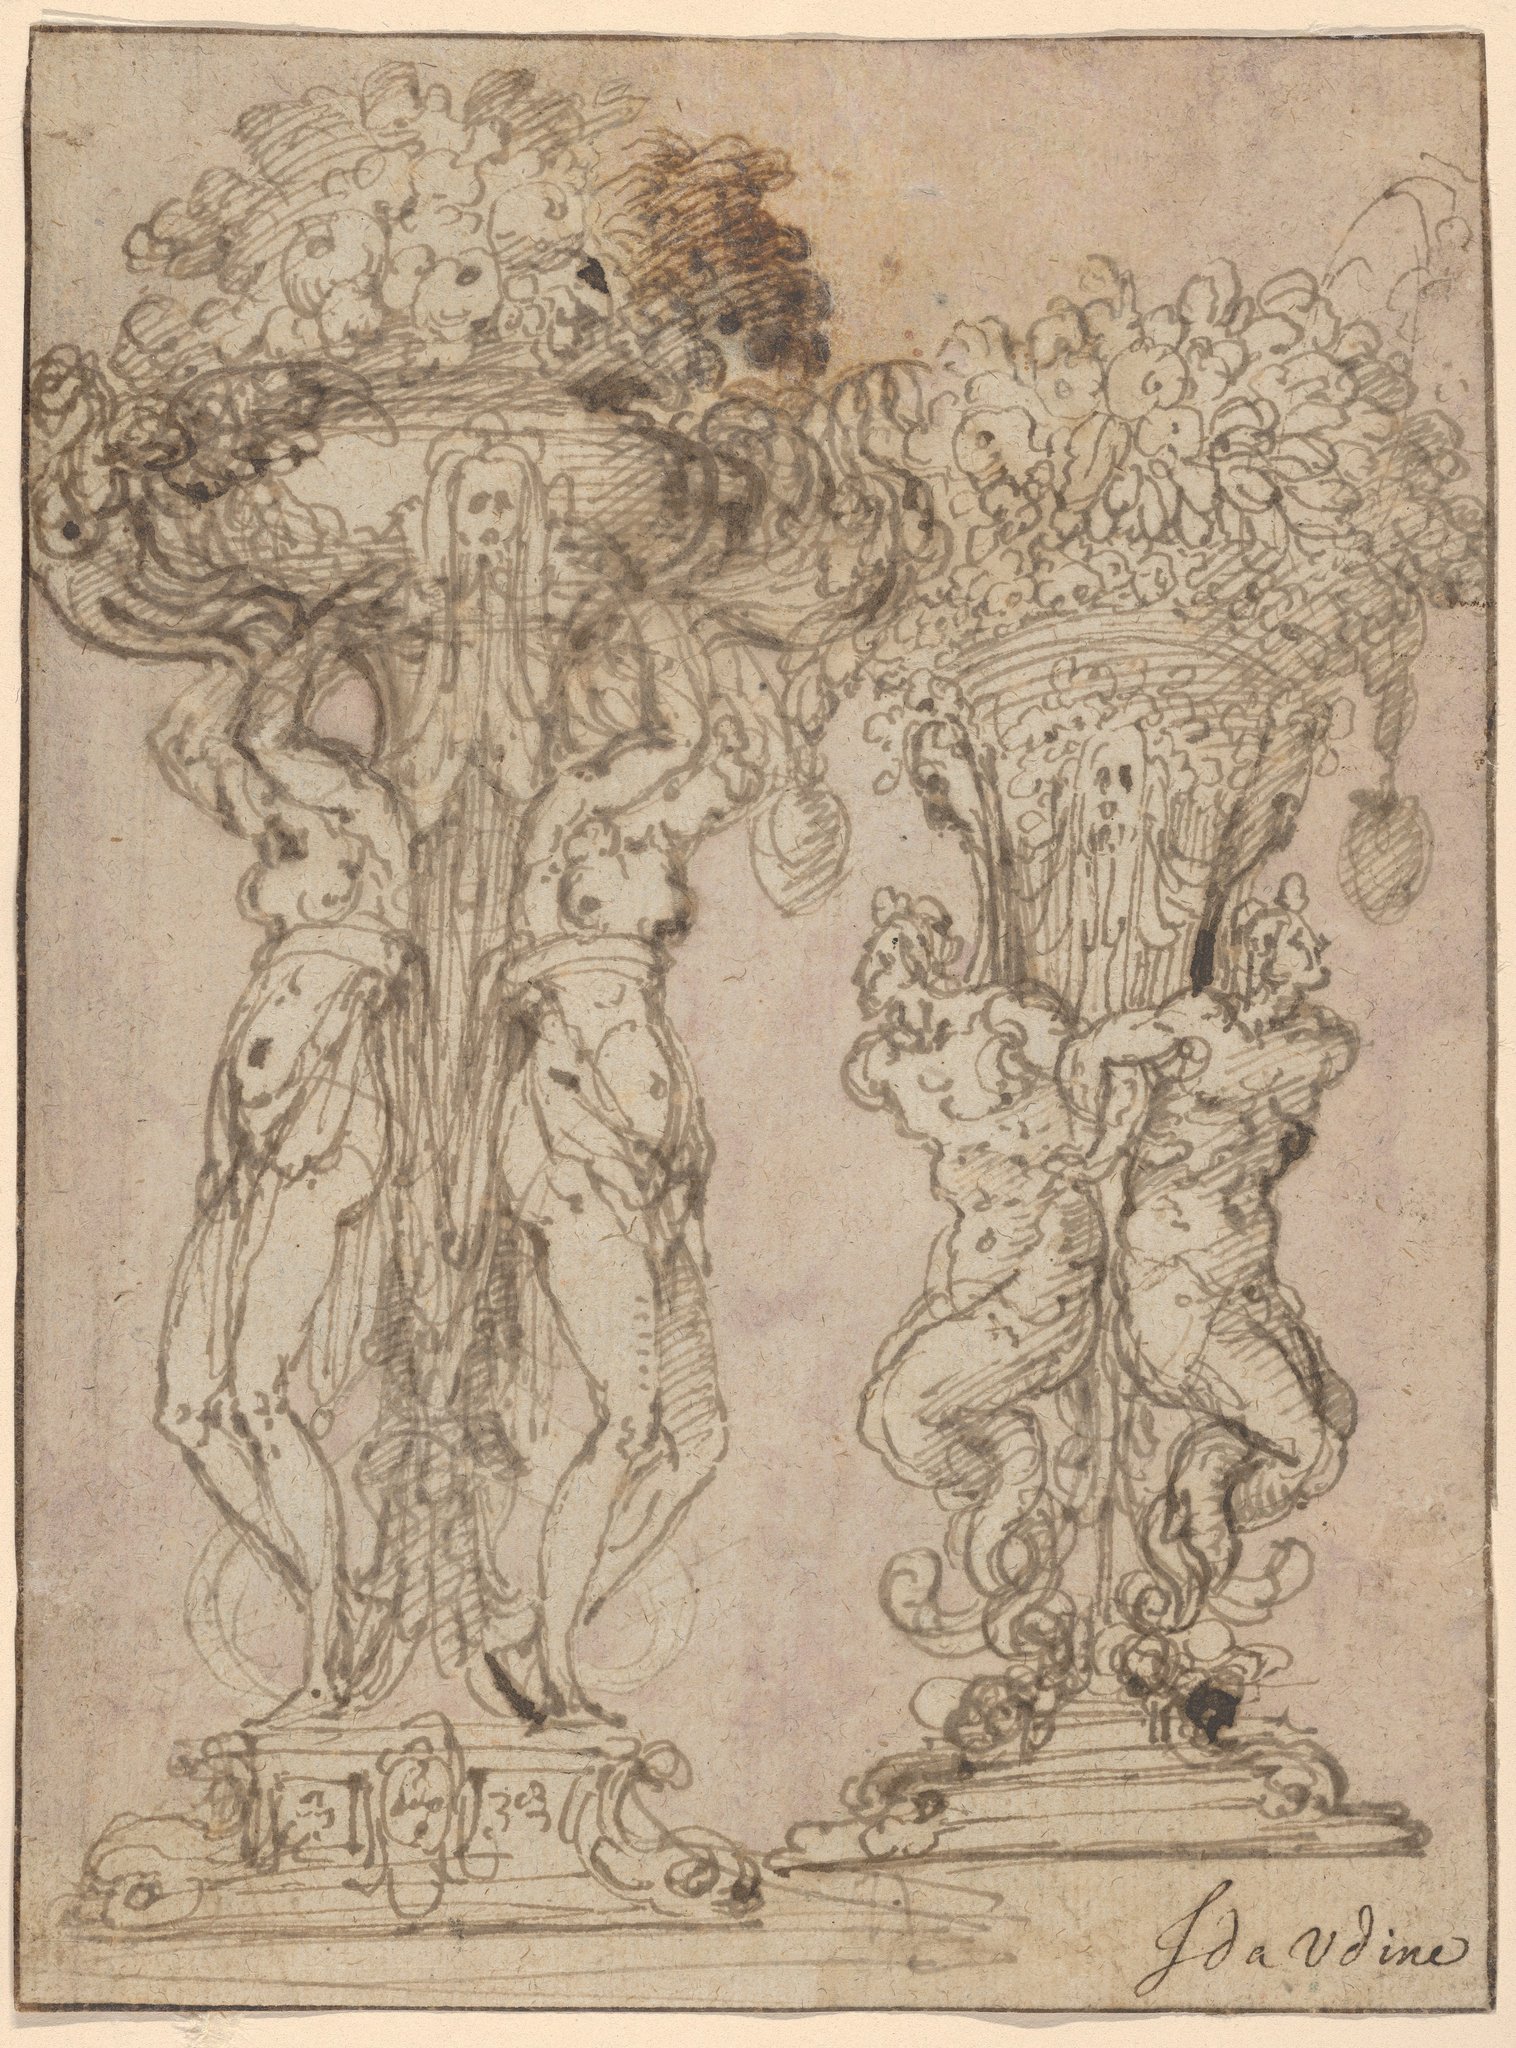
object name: drawing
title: Two Designs for a Flower Pedestal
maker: guglielmo della porta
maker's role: artist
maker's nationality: italian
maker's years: 1500-1577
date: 1550-1570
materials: ink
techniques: brush, pen, wash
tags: caryatids,flowers